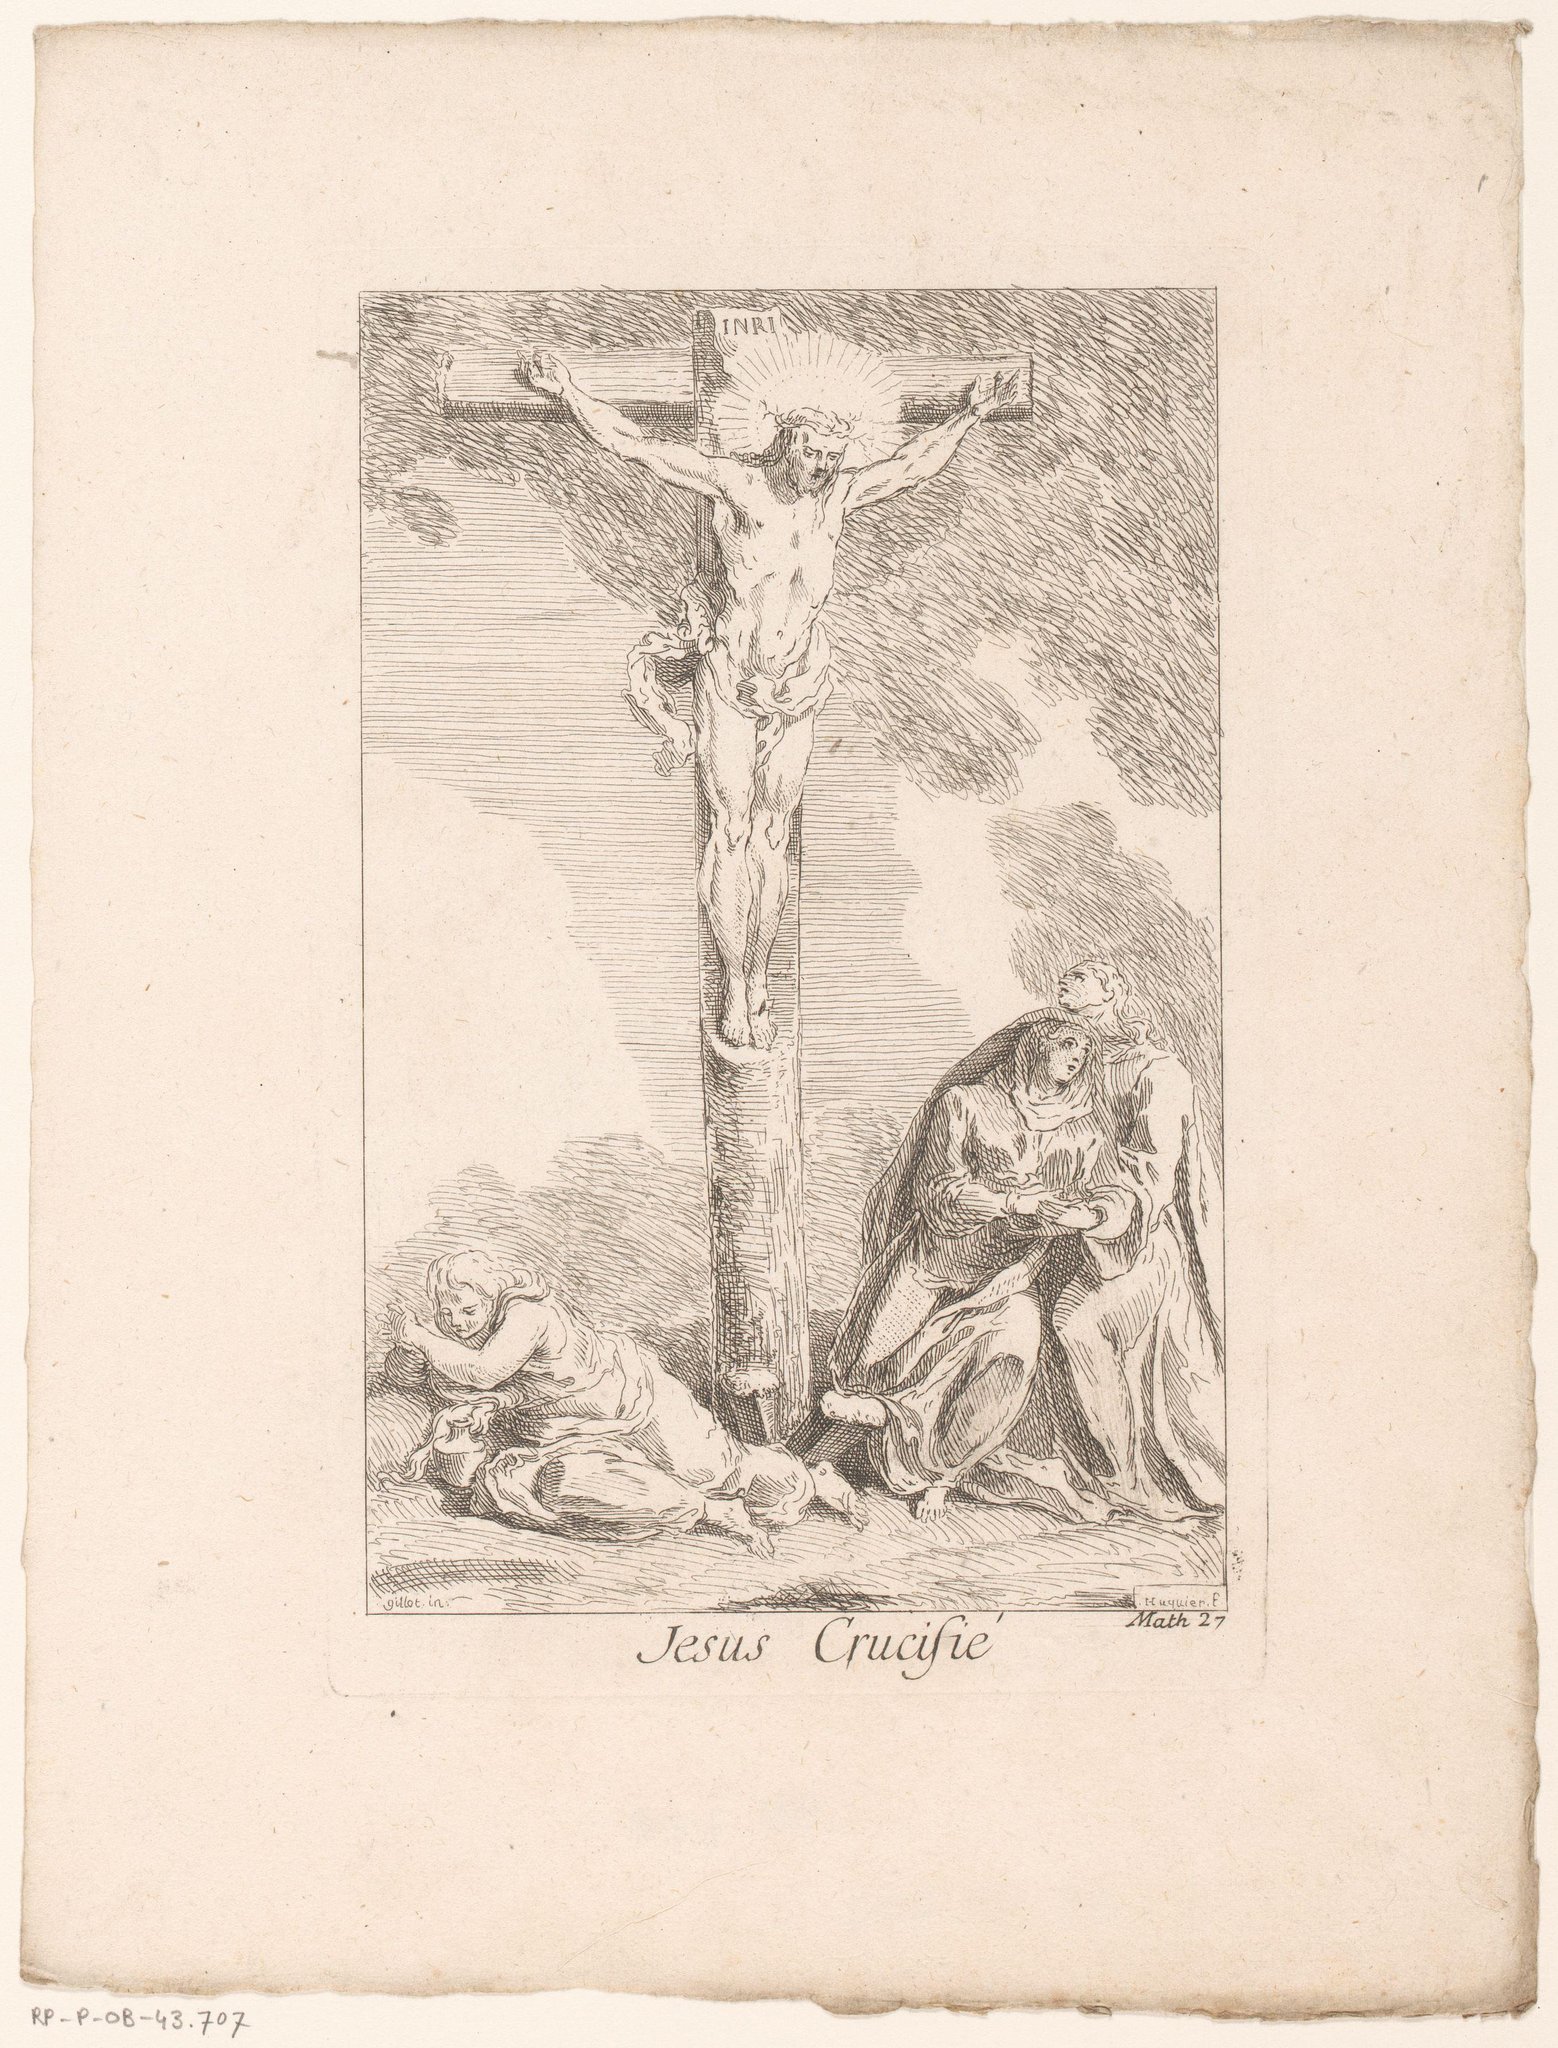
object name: print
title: Jesus Crucifié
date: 1705-1732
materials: paper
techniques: etching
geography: france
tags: the crucifixion of christ: christ's death on the cross; golgotha (matthew 27:45-58; mark 15:33-45; luke 23:44-52; john 19:25-38)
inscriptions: collector's mark: Lugt 2228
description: Maakt deel uit van een serie met zestig prenten met als thema het leven van Christus.